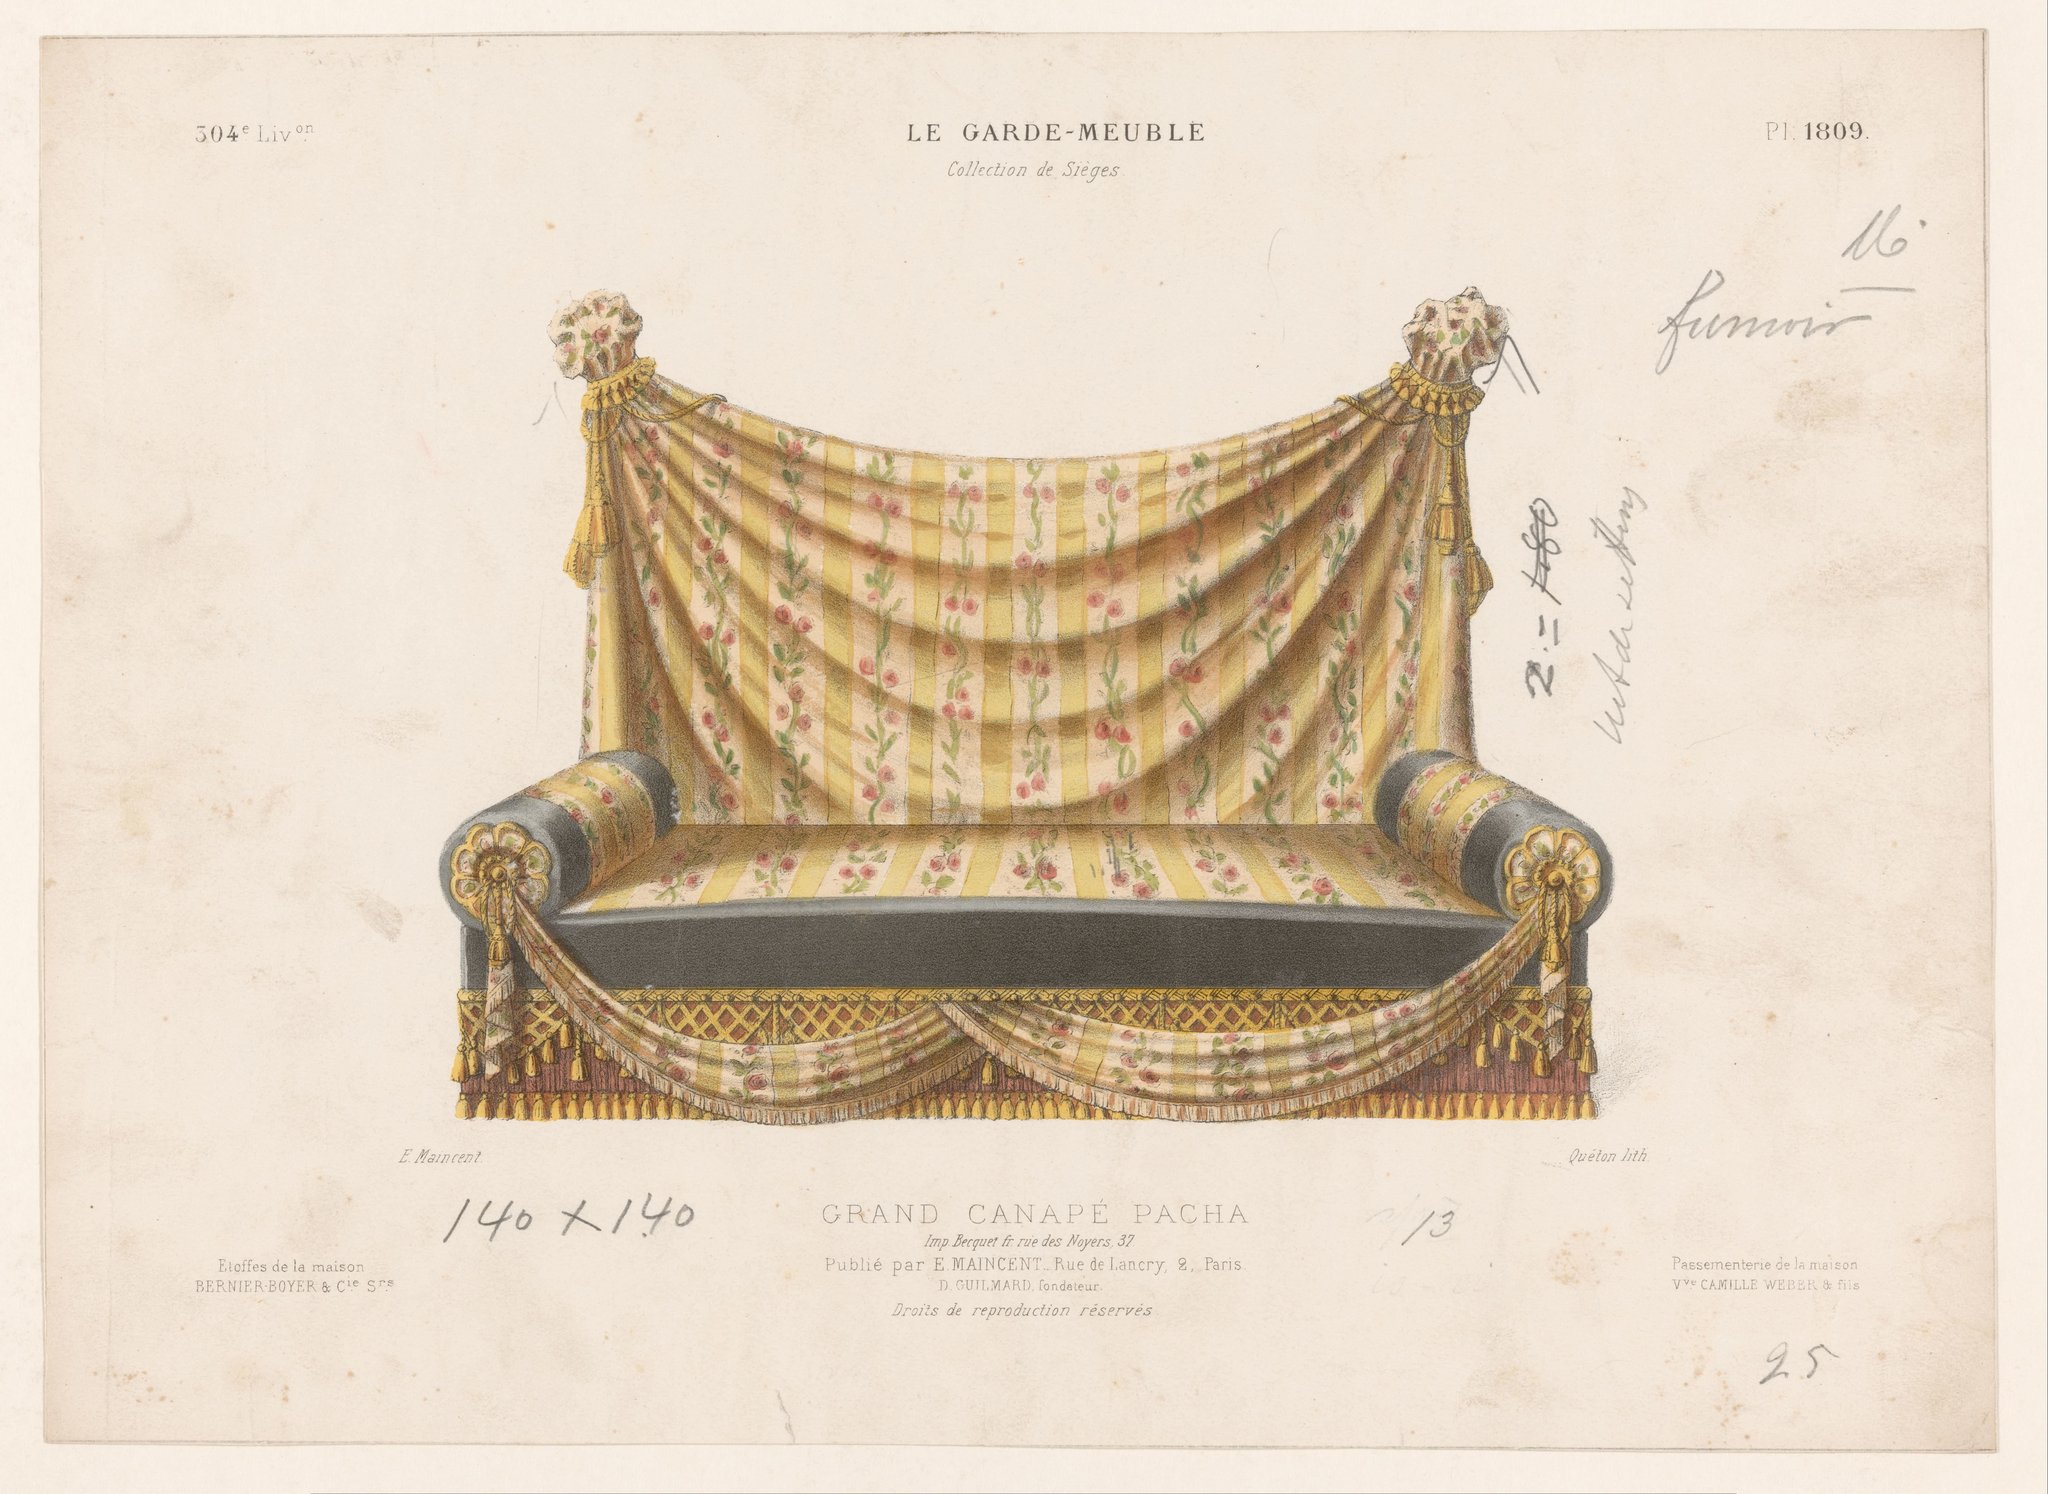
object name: print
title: Grand canapé pacha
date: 1885-1895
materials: paper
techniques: hand coloring, lithograph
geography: paris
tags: seating furniture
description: Ieder Livraison in de serie Le Garde-Meuble bevat negen platen: drie 'sièges' (zitmeubels), drie 'meubles' (diverse meubels zoals tafels en kasten) en drie 'tentures' (gordijnen en draperieën).